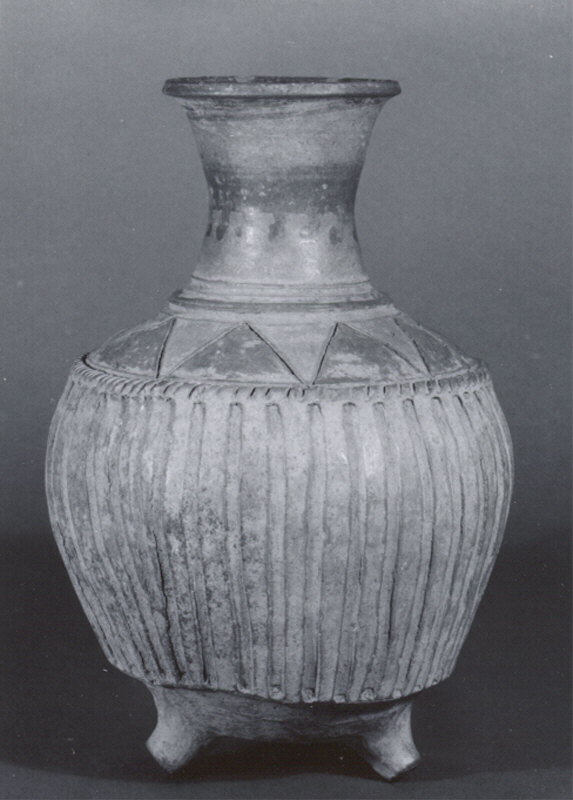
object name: vessel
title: Twin-spouted vessel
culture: iranian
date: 700-501 BCE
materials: ceramic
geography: northwestern iran